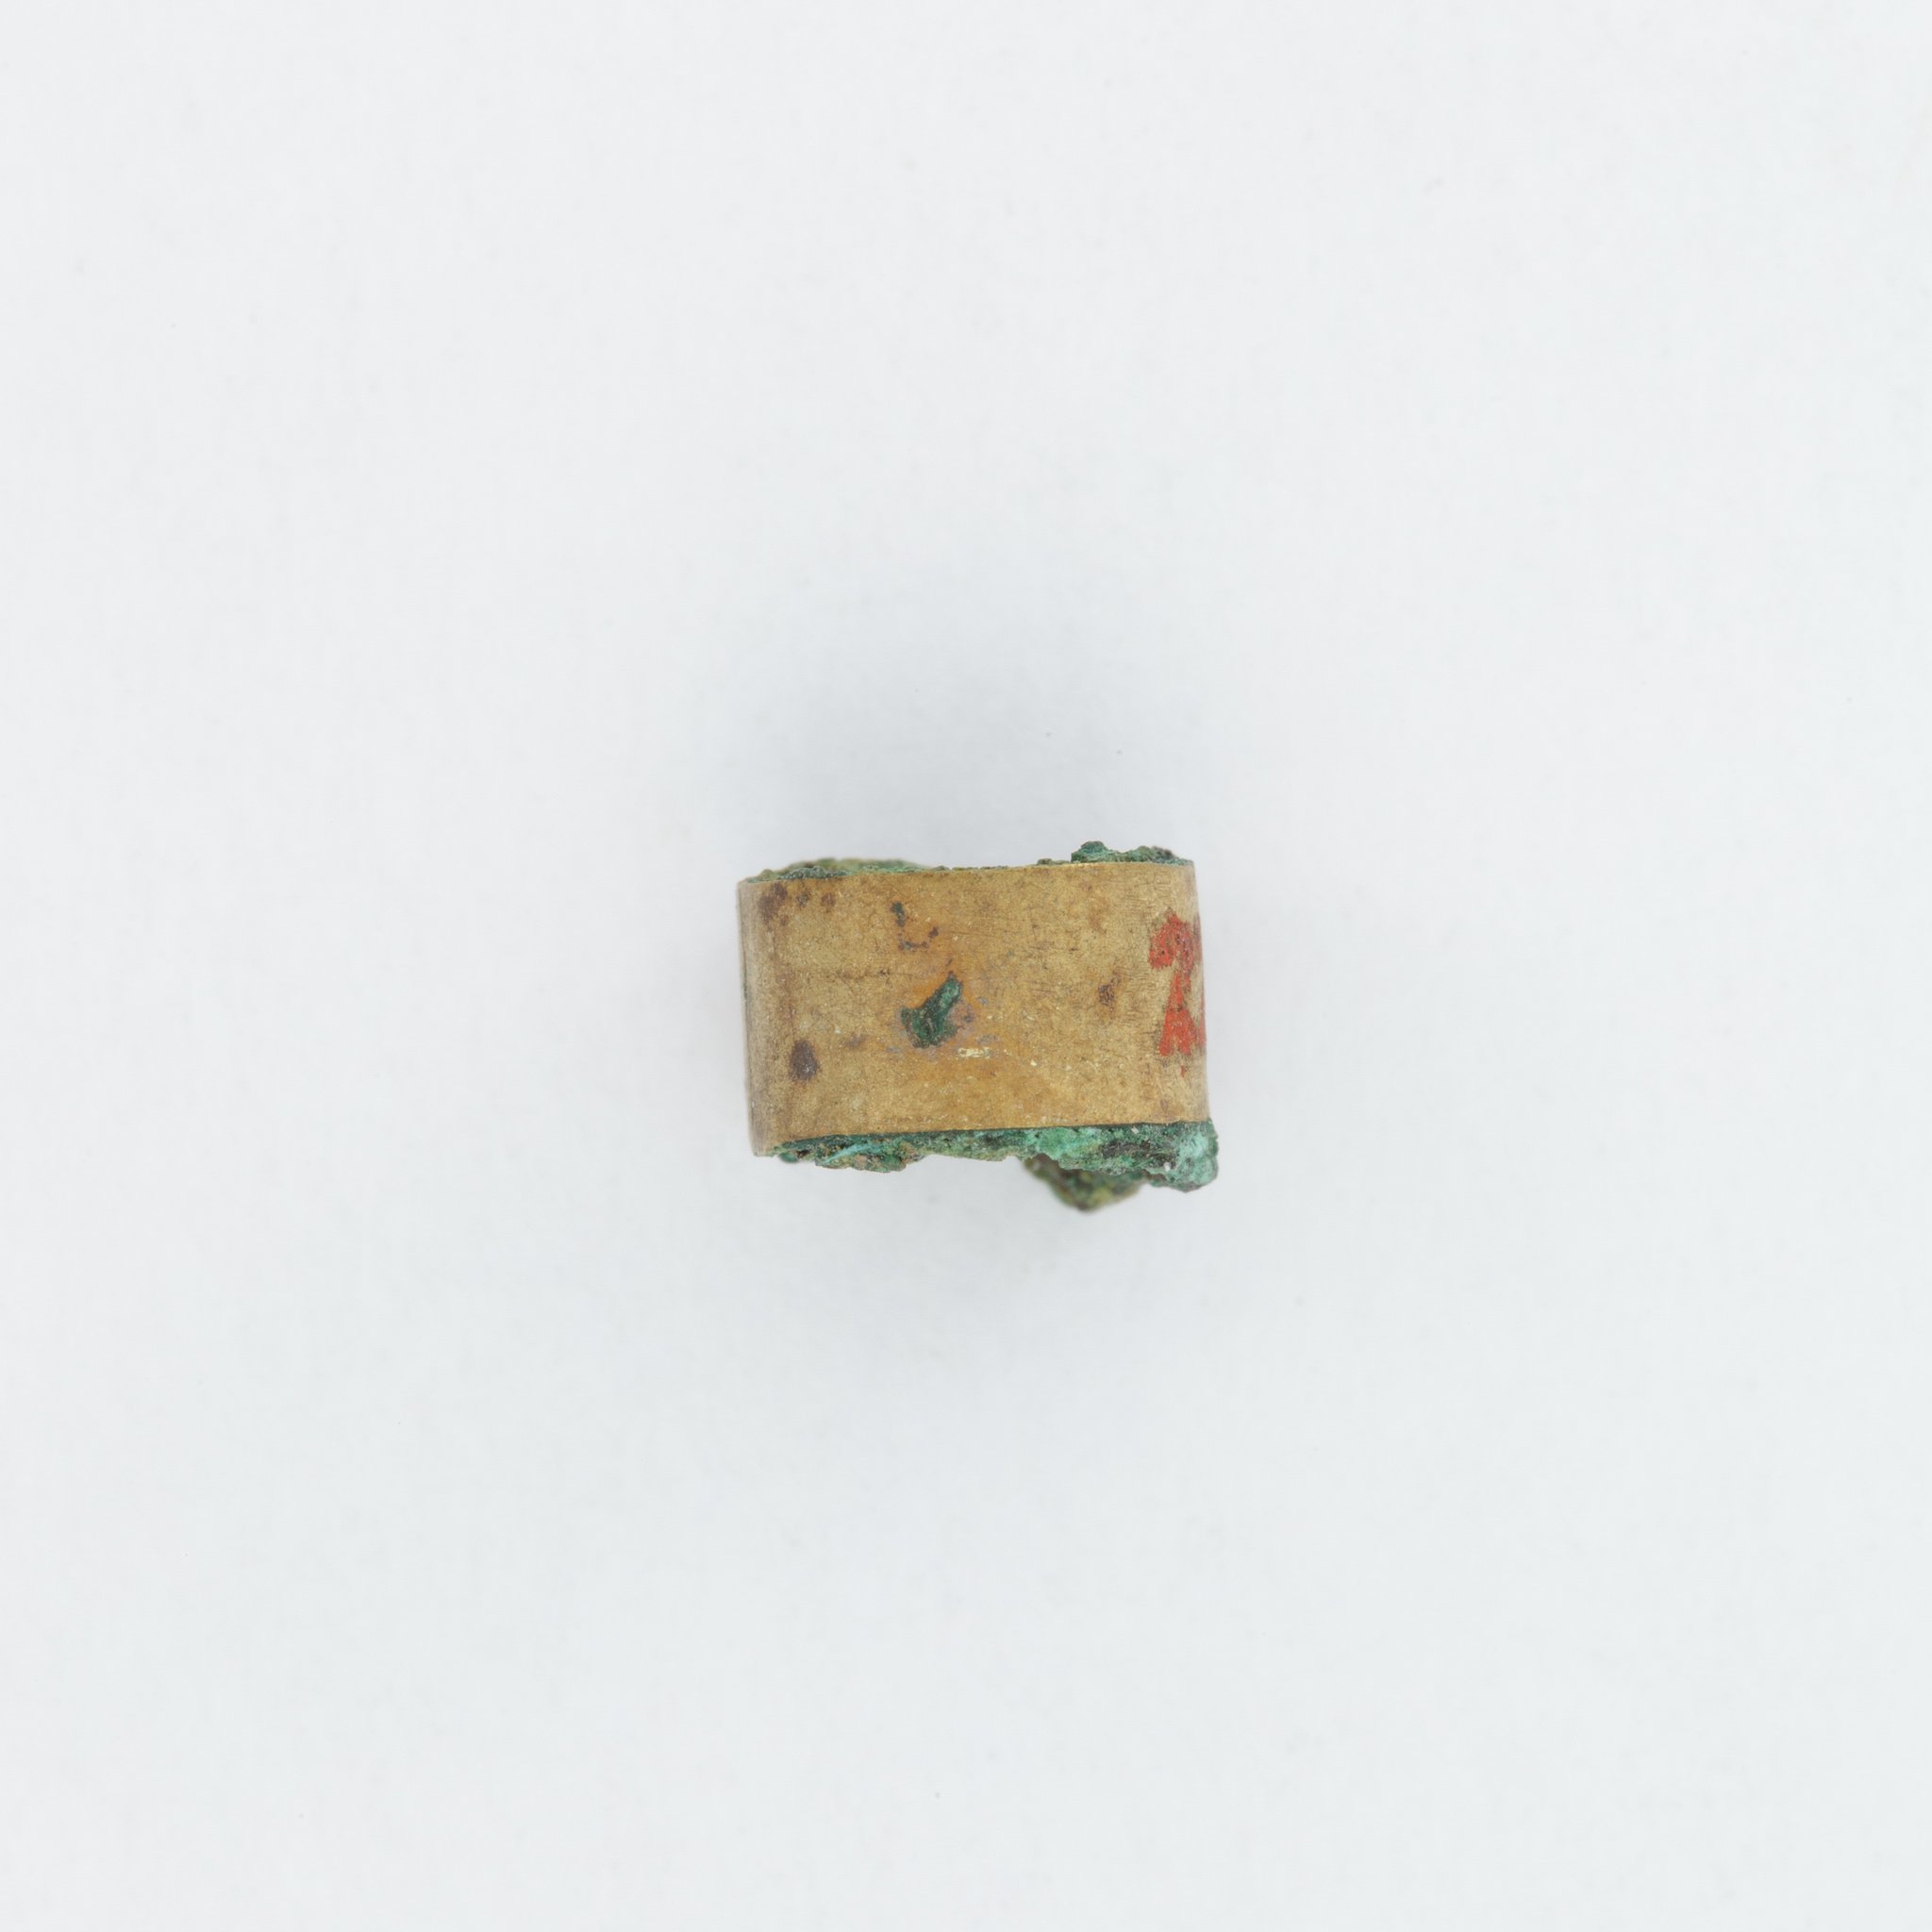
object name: fragment, cylindrical pendant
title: Pieces from a cylindrical pendant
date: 1750 BCE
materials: copper alloy, gold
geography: egypt